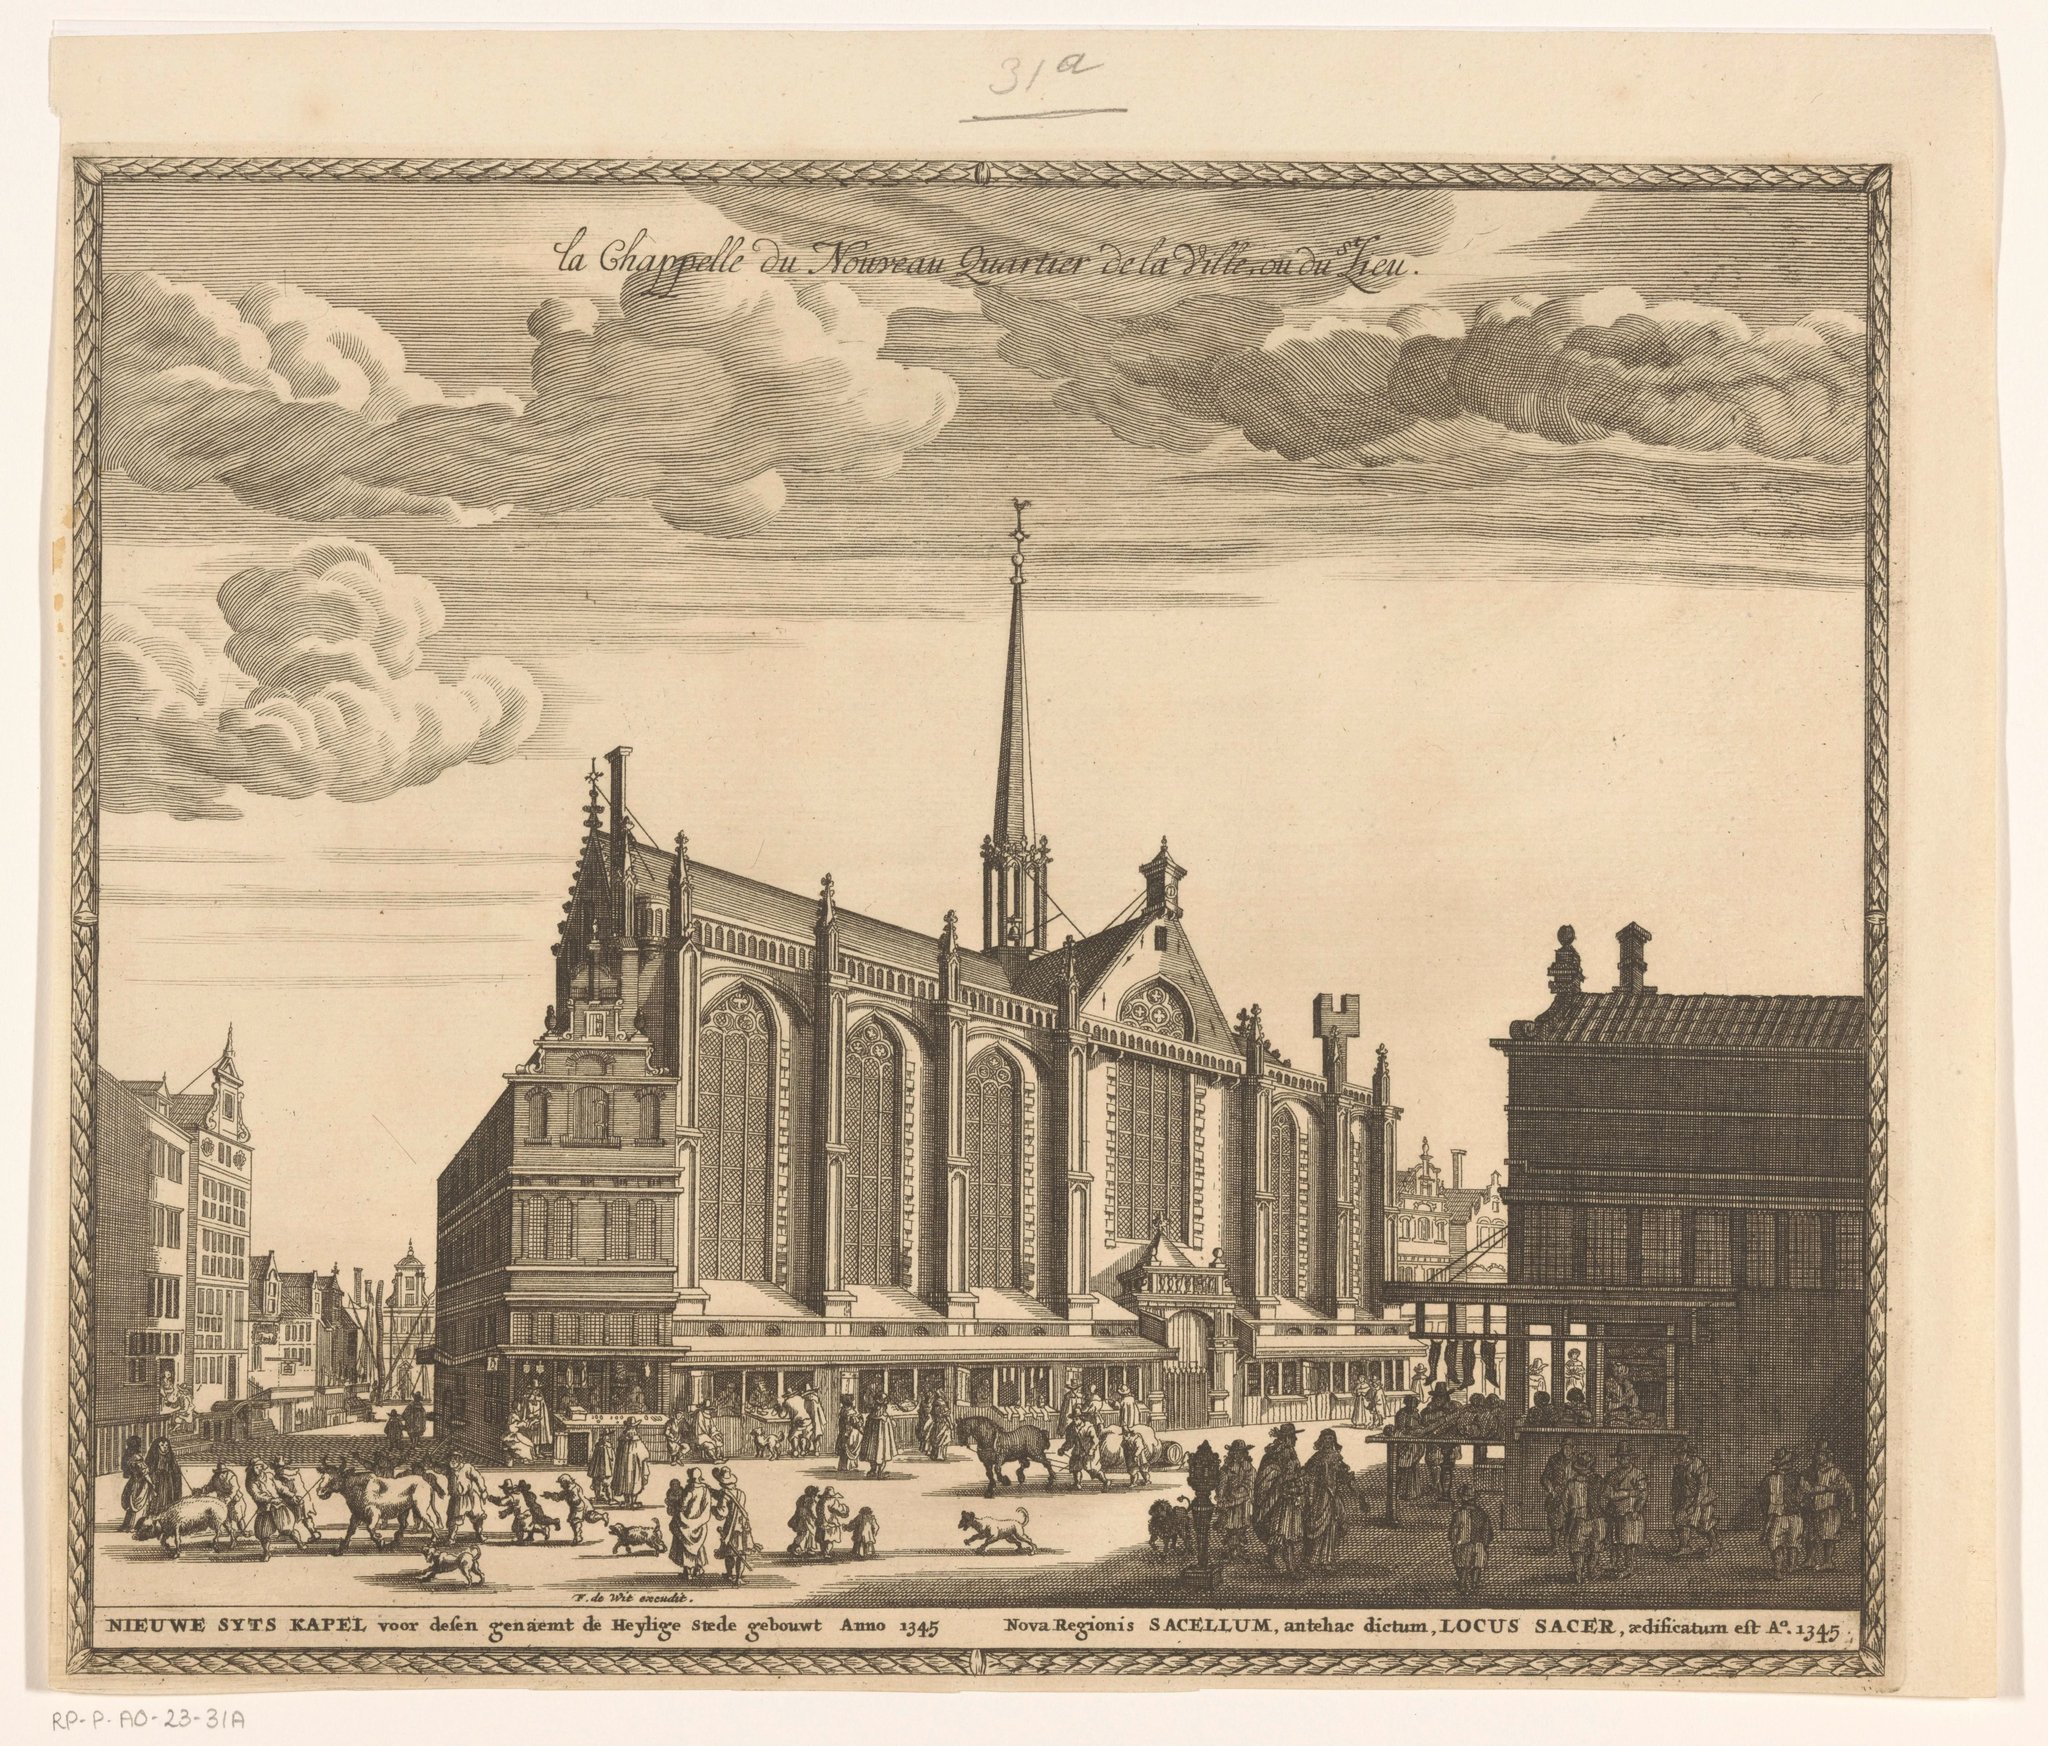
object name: print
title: Nieuwe Syts Kapel voor desen genaemt de Heylige Stede gebouwt Anno 1345 / Nova Regionis Sacellum, antehac dictum, Locus Sacer, aedificatum est Ao. 1345 / la Chappelle du Nouveau Quartier de la Ville, ou du St. Lieu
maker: Anonymous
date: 1662-1728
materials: paper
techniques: engraving, etching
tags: church (exterior) - qq - small church, chapel, street (+ city(-scape) with figures, staffage)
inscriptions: collector's mark: Lugt 2228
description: Prent ook gebruikt in: La celebre ville d'Amsterdam, representée dans toute sa splendeur et sa magnificence (...) / De heerlykheid der wyd-vermaerde stad Amsterdam (…). Leiden: Pieter van der Aa, s.a. En in: Aa, Pieter van der. Europa. Leiden: Pieter van der Aa, s.a. [ca. 1715]. En in: Aa, Pieter van der. La galerie agreable du monde (...). 66 delen. Leiden: Pieter van der Aa, 1728, dl. 17. Zie ook RP-P-AO-23-31.